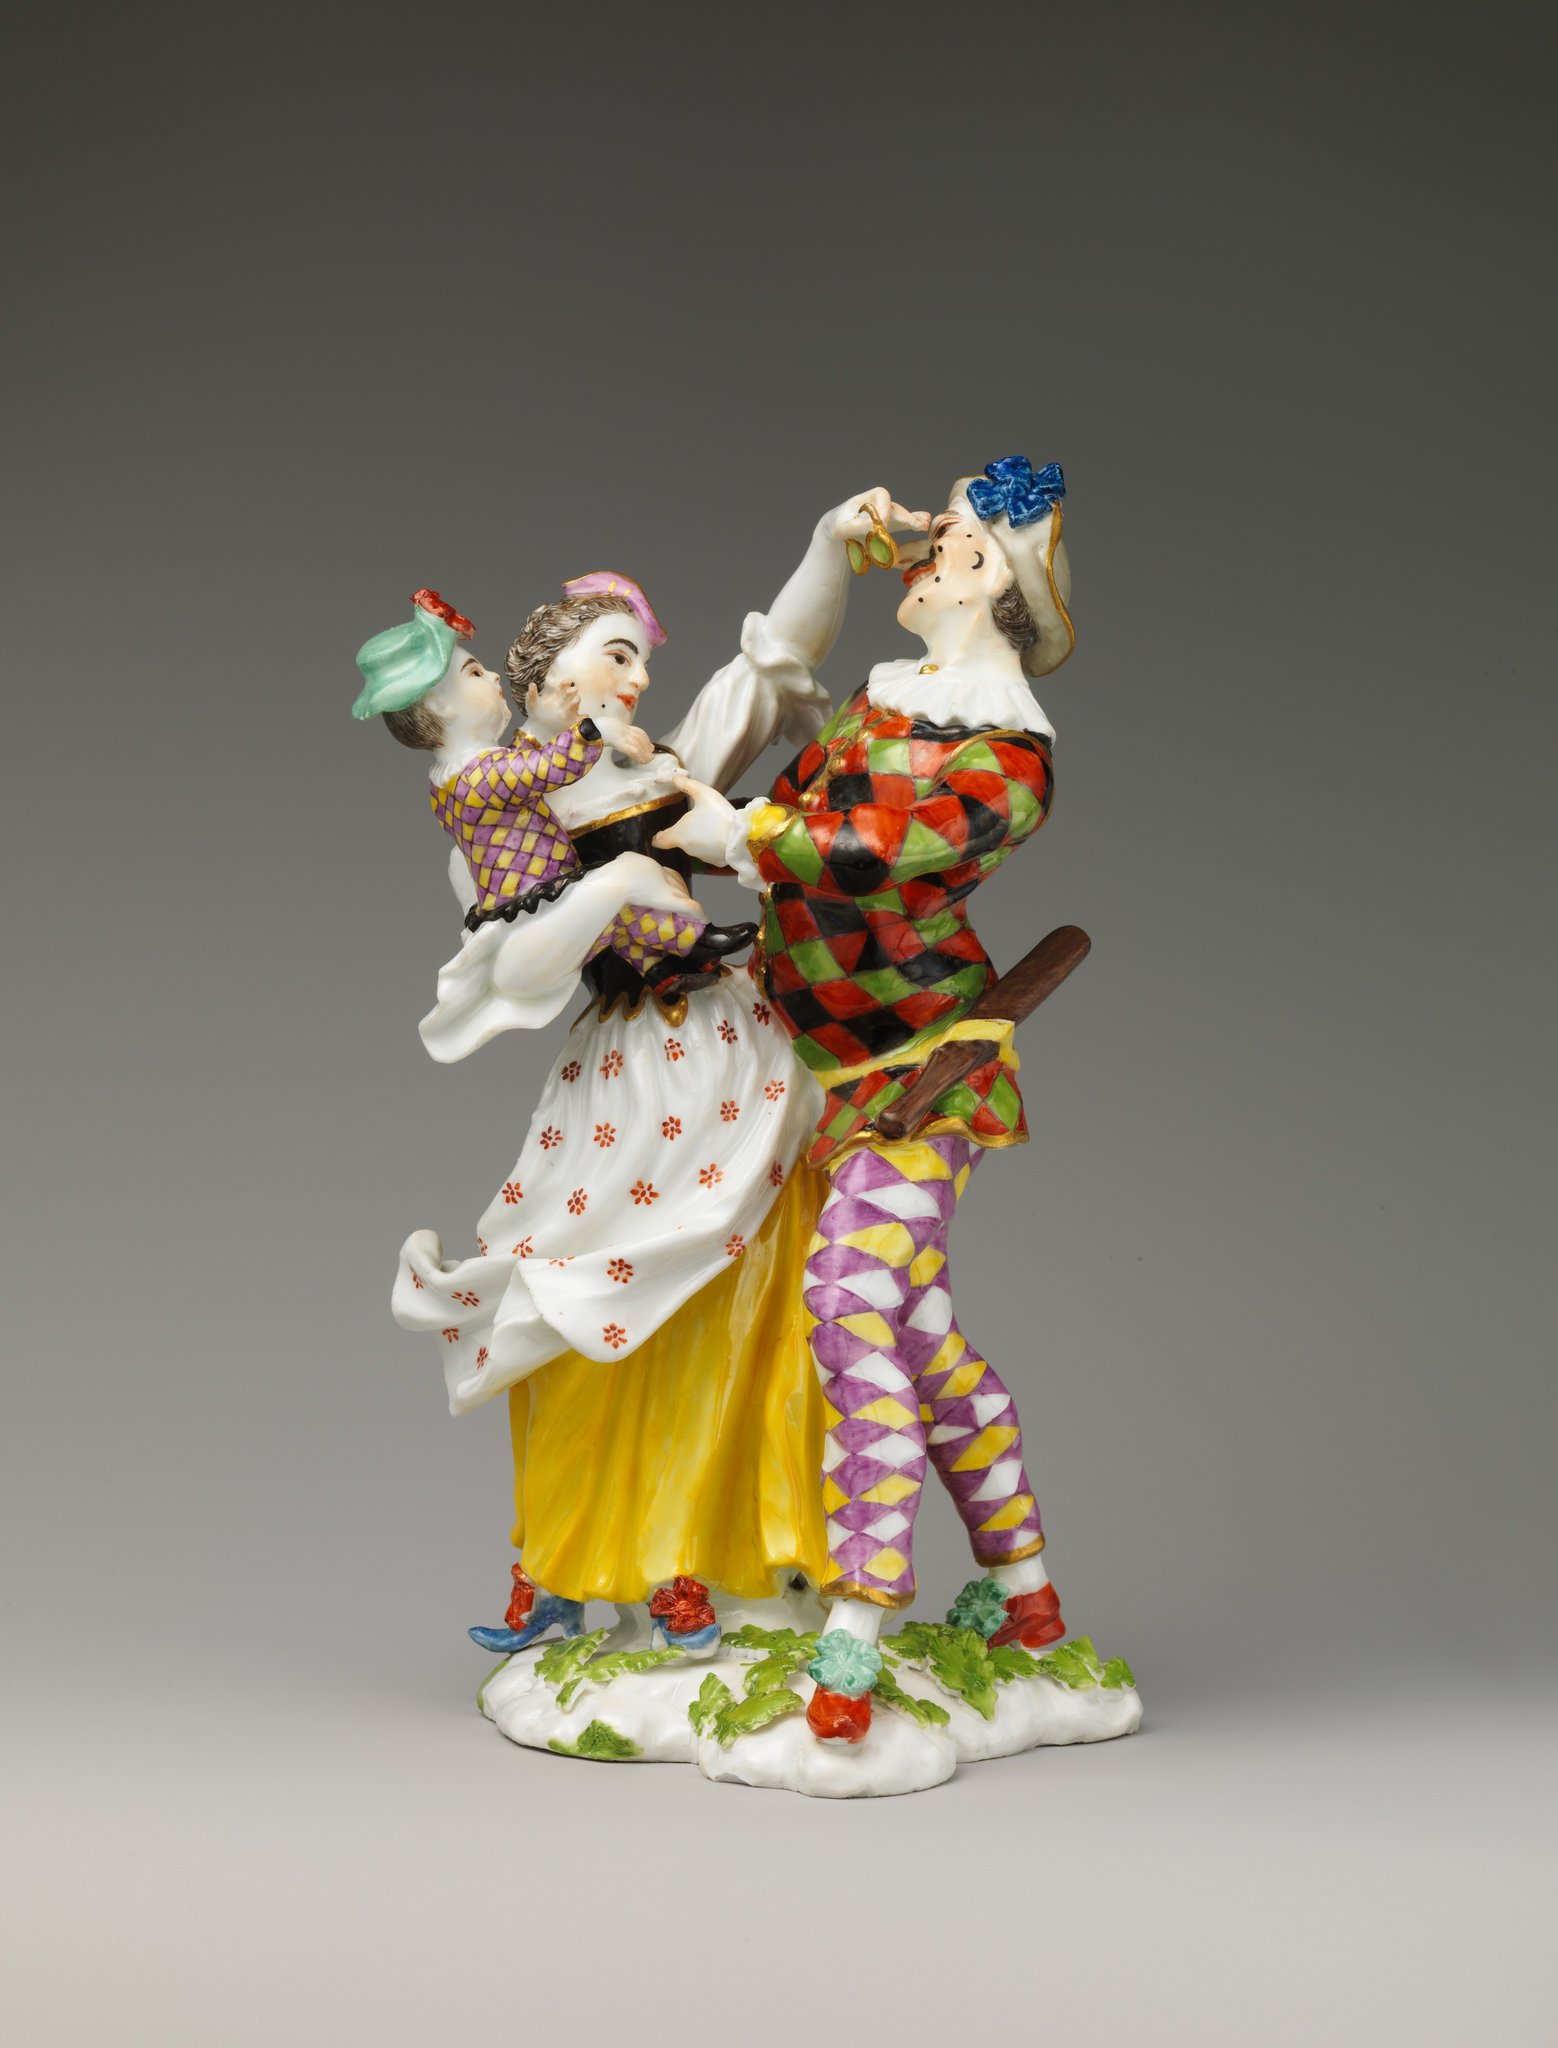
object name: group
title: Harlequin family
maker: meissen manufactory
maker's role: manufactory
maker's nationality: german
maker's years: 1710-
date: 1738-1740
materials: enamel, gold, hard paste porcelain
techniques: polychrome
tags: children,men,women,family